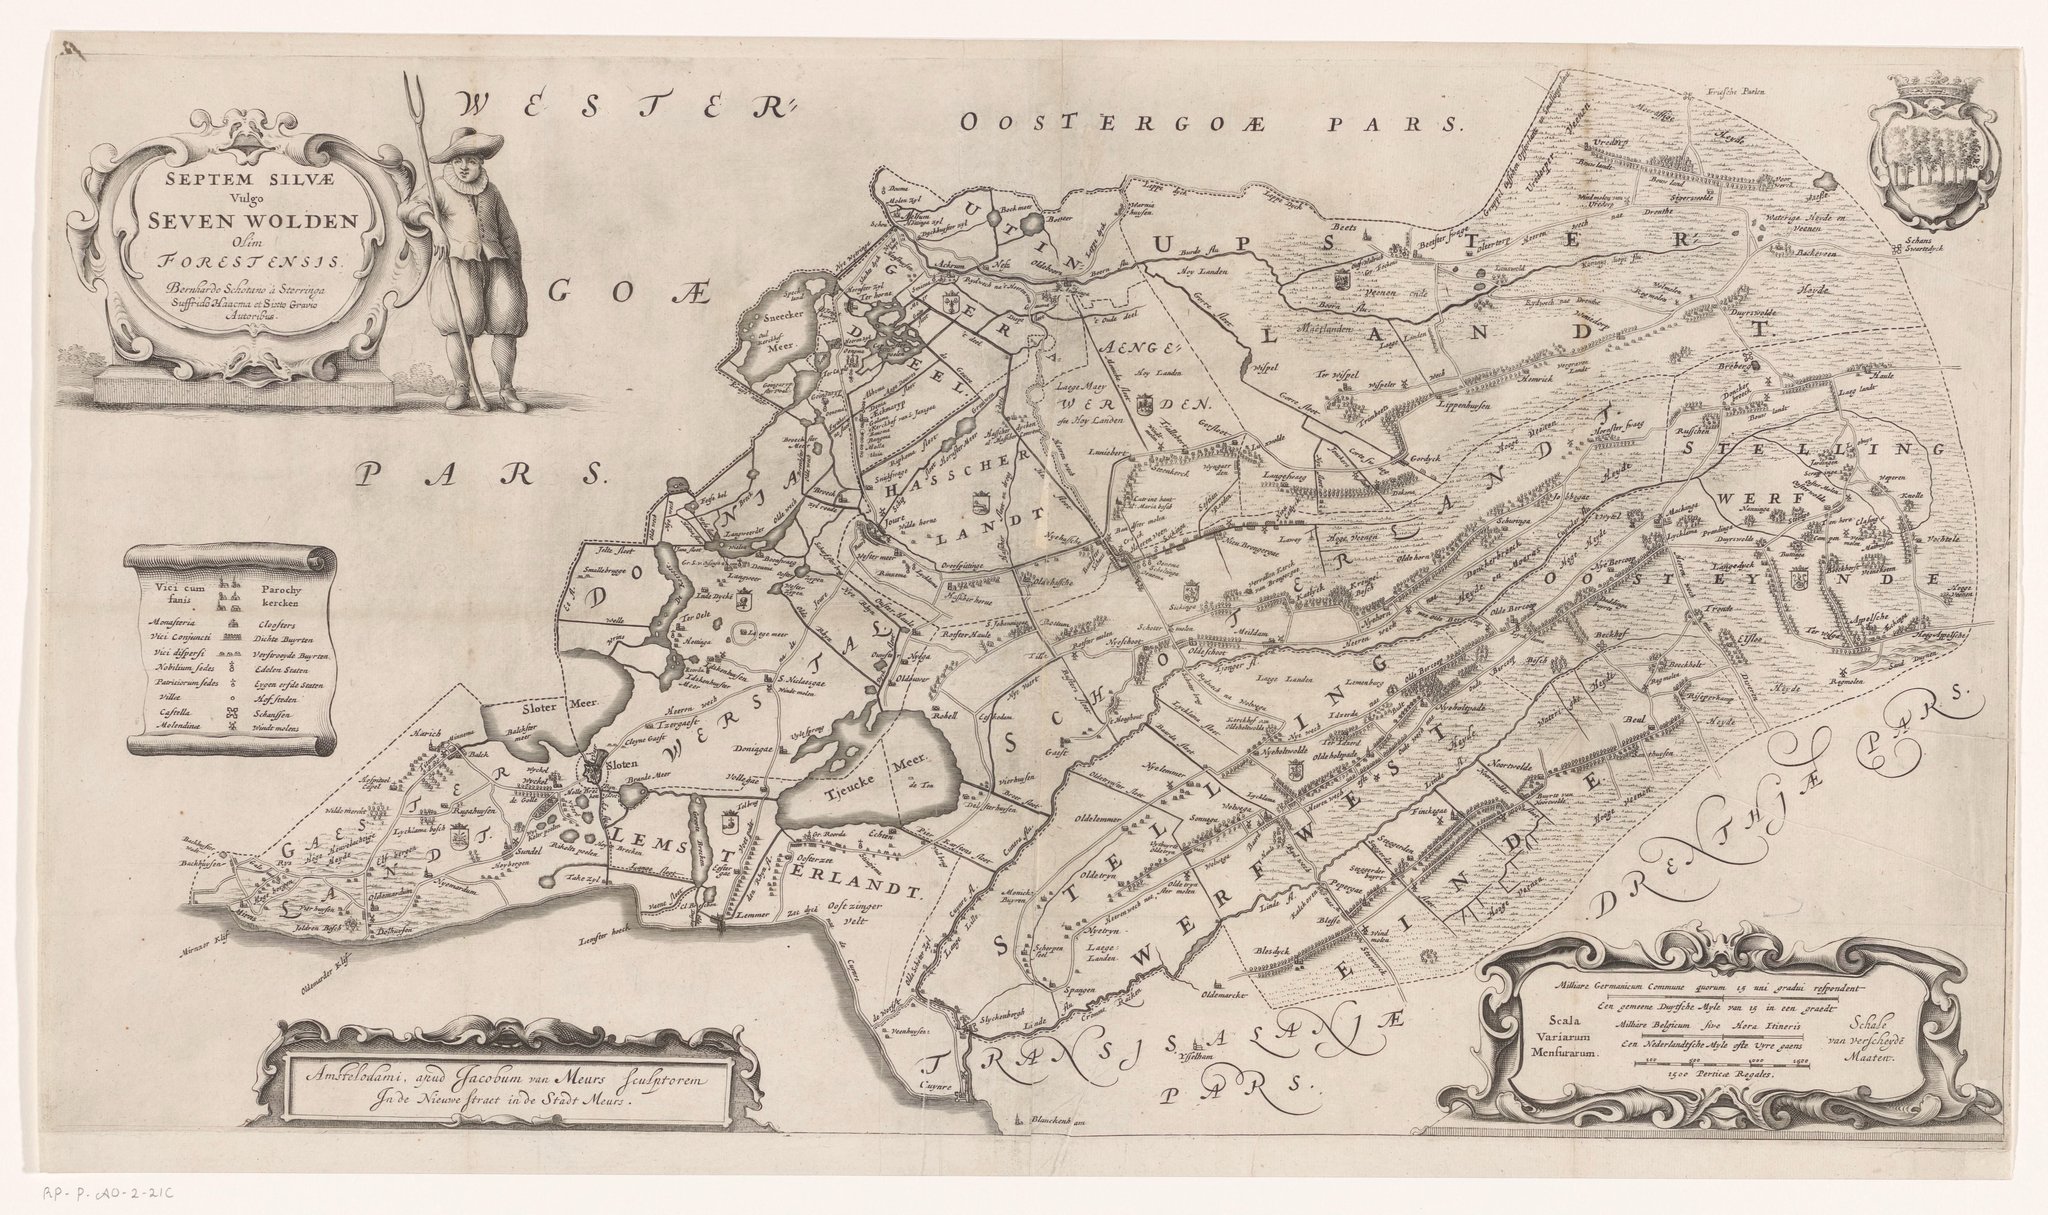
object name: map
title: Kaart van het kwartier Zevenwouden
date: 1664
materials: paper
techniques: engraving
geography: friesland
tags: coat of arms (as symbol of the state, etc.), maps of separate countries or regions, farmers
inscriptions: collector's mark: Lugt 2228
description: Linksboven titelcartouche met daarnaast een manfiguur met een hooivork, daaronder legenda. Rechtsboven het wapen van Zevenwouden, rechtsonder drie schaalstokken: Milliare Germanicum commune quorum 15 uni gradui respondent / Een gemeene Duytsche myle van 15 in een graedt, Milliare Belgicum sive hora itineris / Een Nederlandtsche myle ofte uyre gaens, 1500 perticae regales.